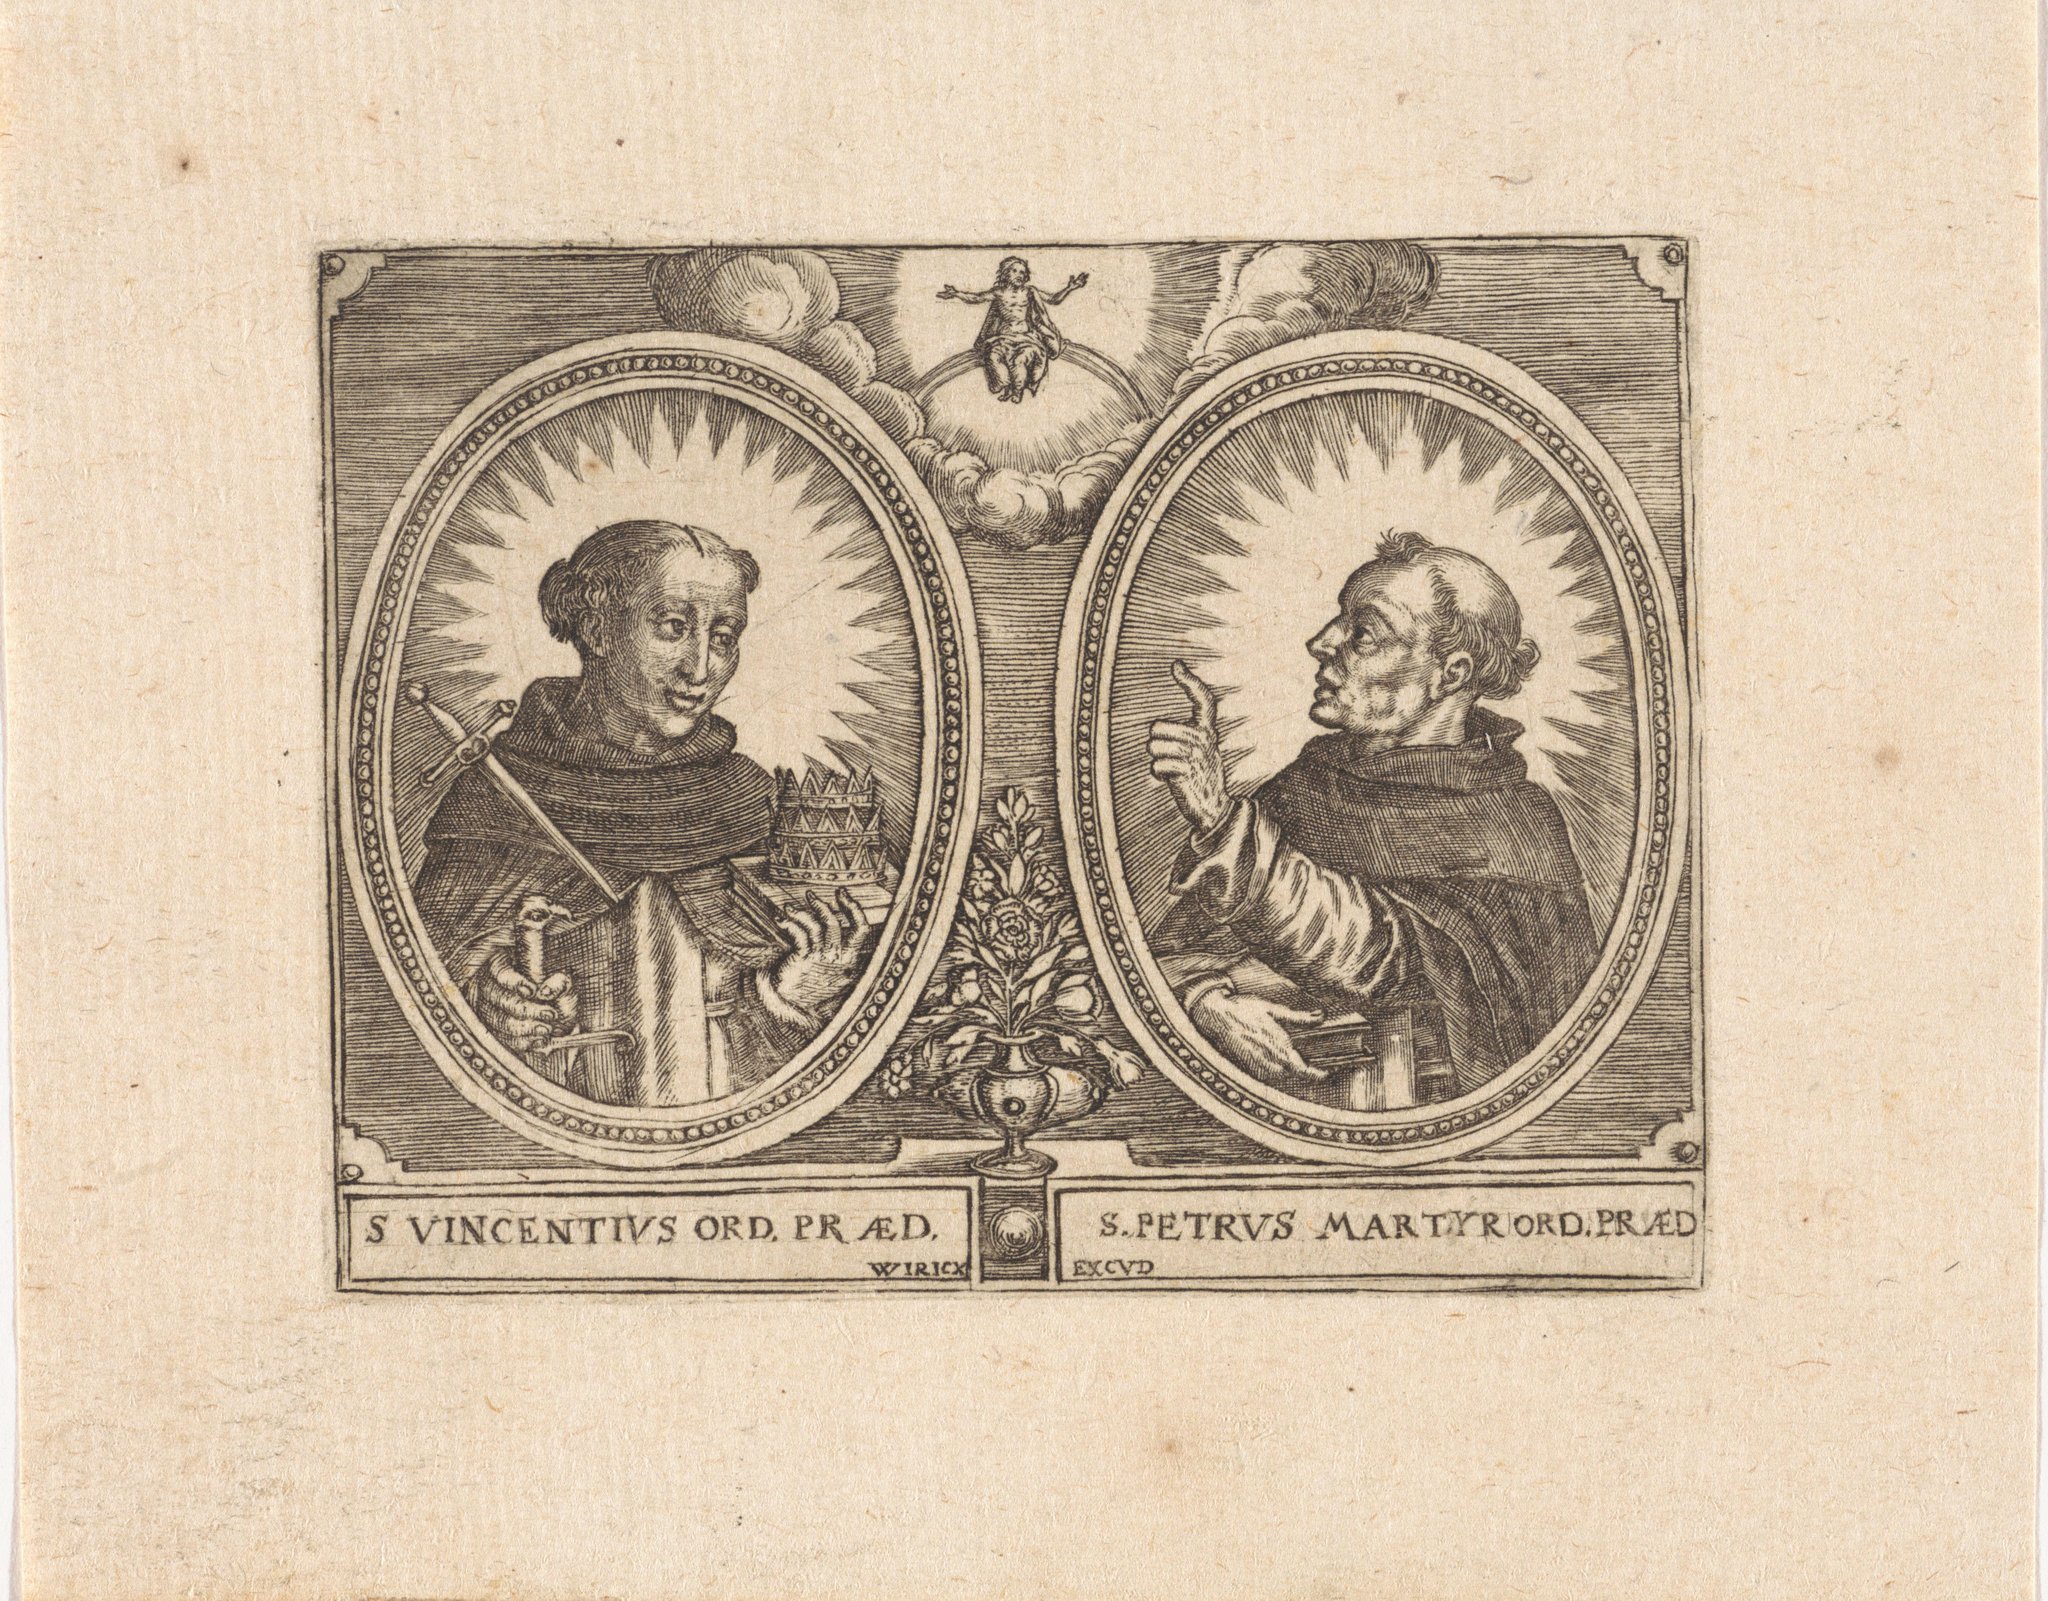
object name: print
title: H. Vincentius Ferrerius en H. Petrus Martyr van Verona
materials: paper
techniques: engraving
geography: antwerp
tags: the dominican friar peter martyr of verona; possible attributes: crucifix, finger at lips, palm, sword (axe or knife) in skull (or breast), wound in head, the dominican friar vincent ferrer of valencia (or vannes); possible attributes: book, baptismal font, cardinal's hat at feet, flames, flaming sword, ihs monogram, lily, sun, trumpet of the last judgement, particular types of adult christ (without others), flowers in a vase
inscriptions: collector's mark: Lugt 2228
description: Links: De heilige Petrus Martyr van Verona, in dominicaner habijt, een wond in zijn schedel en zijn borst met een zwaard doorstoken. In zijn ene hand houdt hij nog een zwaard, in de andere een boek waarop drie kronen liggen. Rechts: De heilige Vincentius Ferrerius, in dominicaner habijt, met boeken in de hand. De namen onder de portretten zijn foutief, vermoedelijk abusievelijk verwisseld. De voorstellingen zijn gevat in ovale omlijstingen, daartussen Christus op de regenboog en een vaas met bloemen.